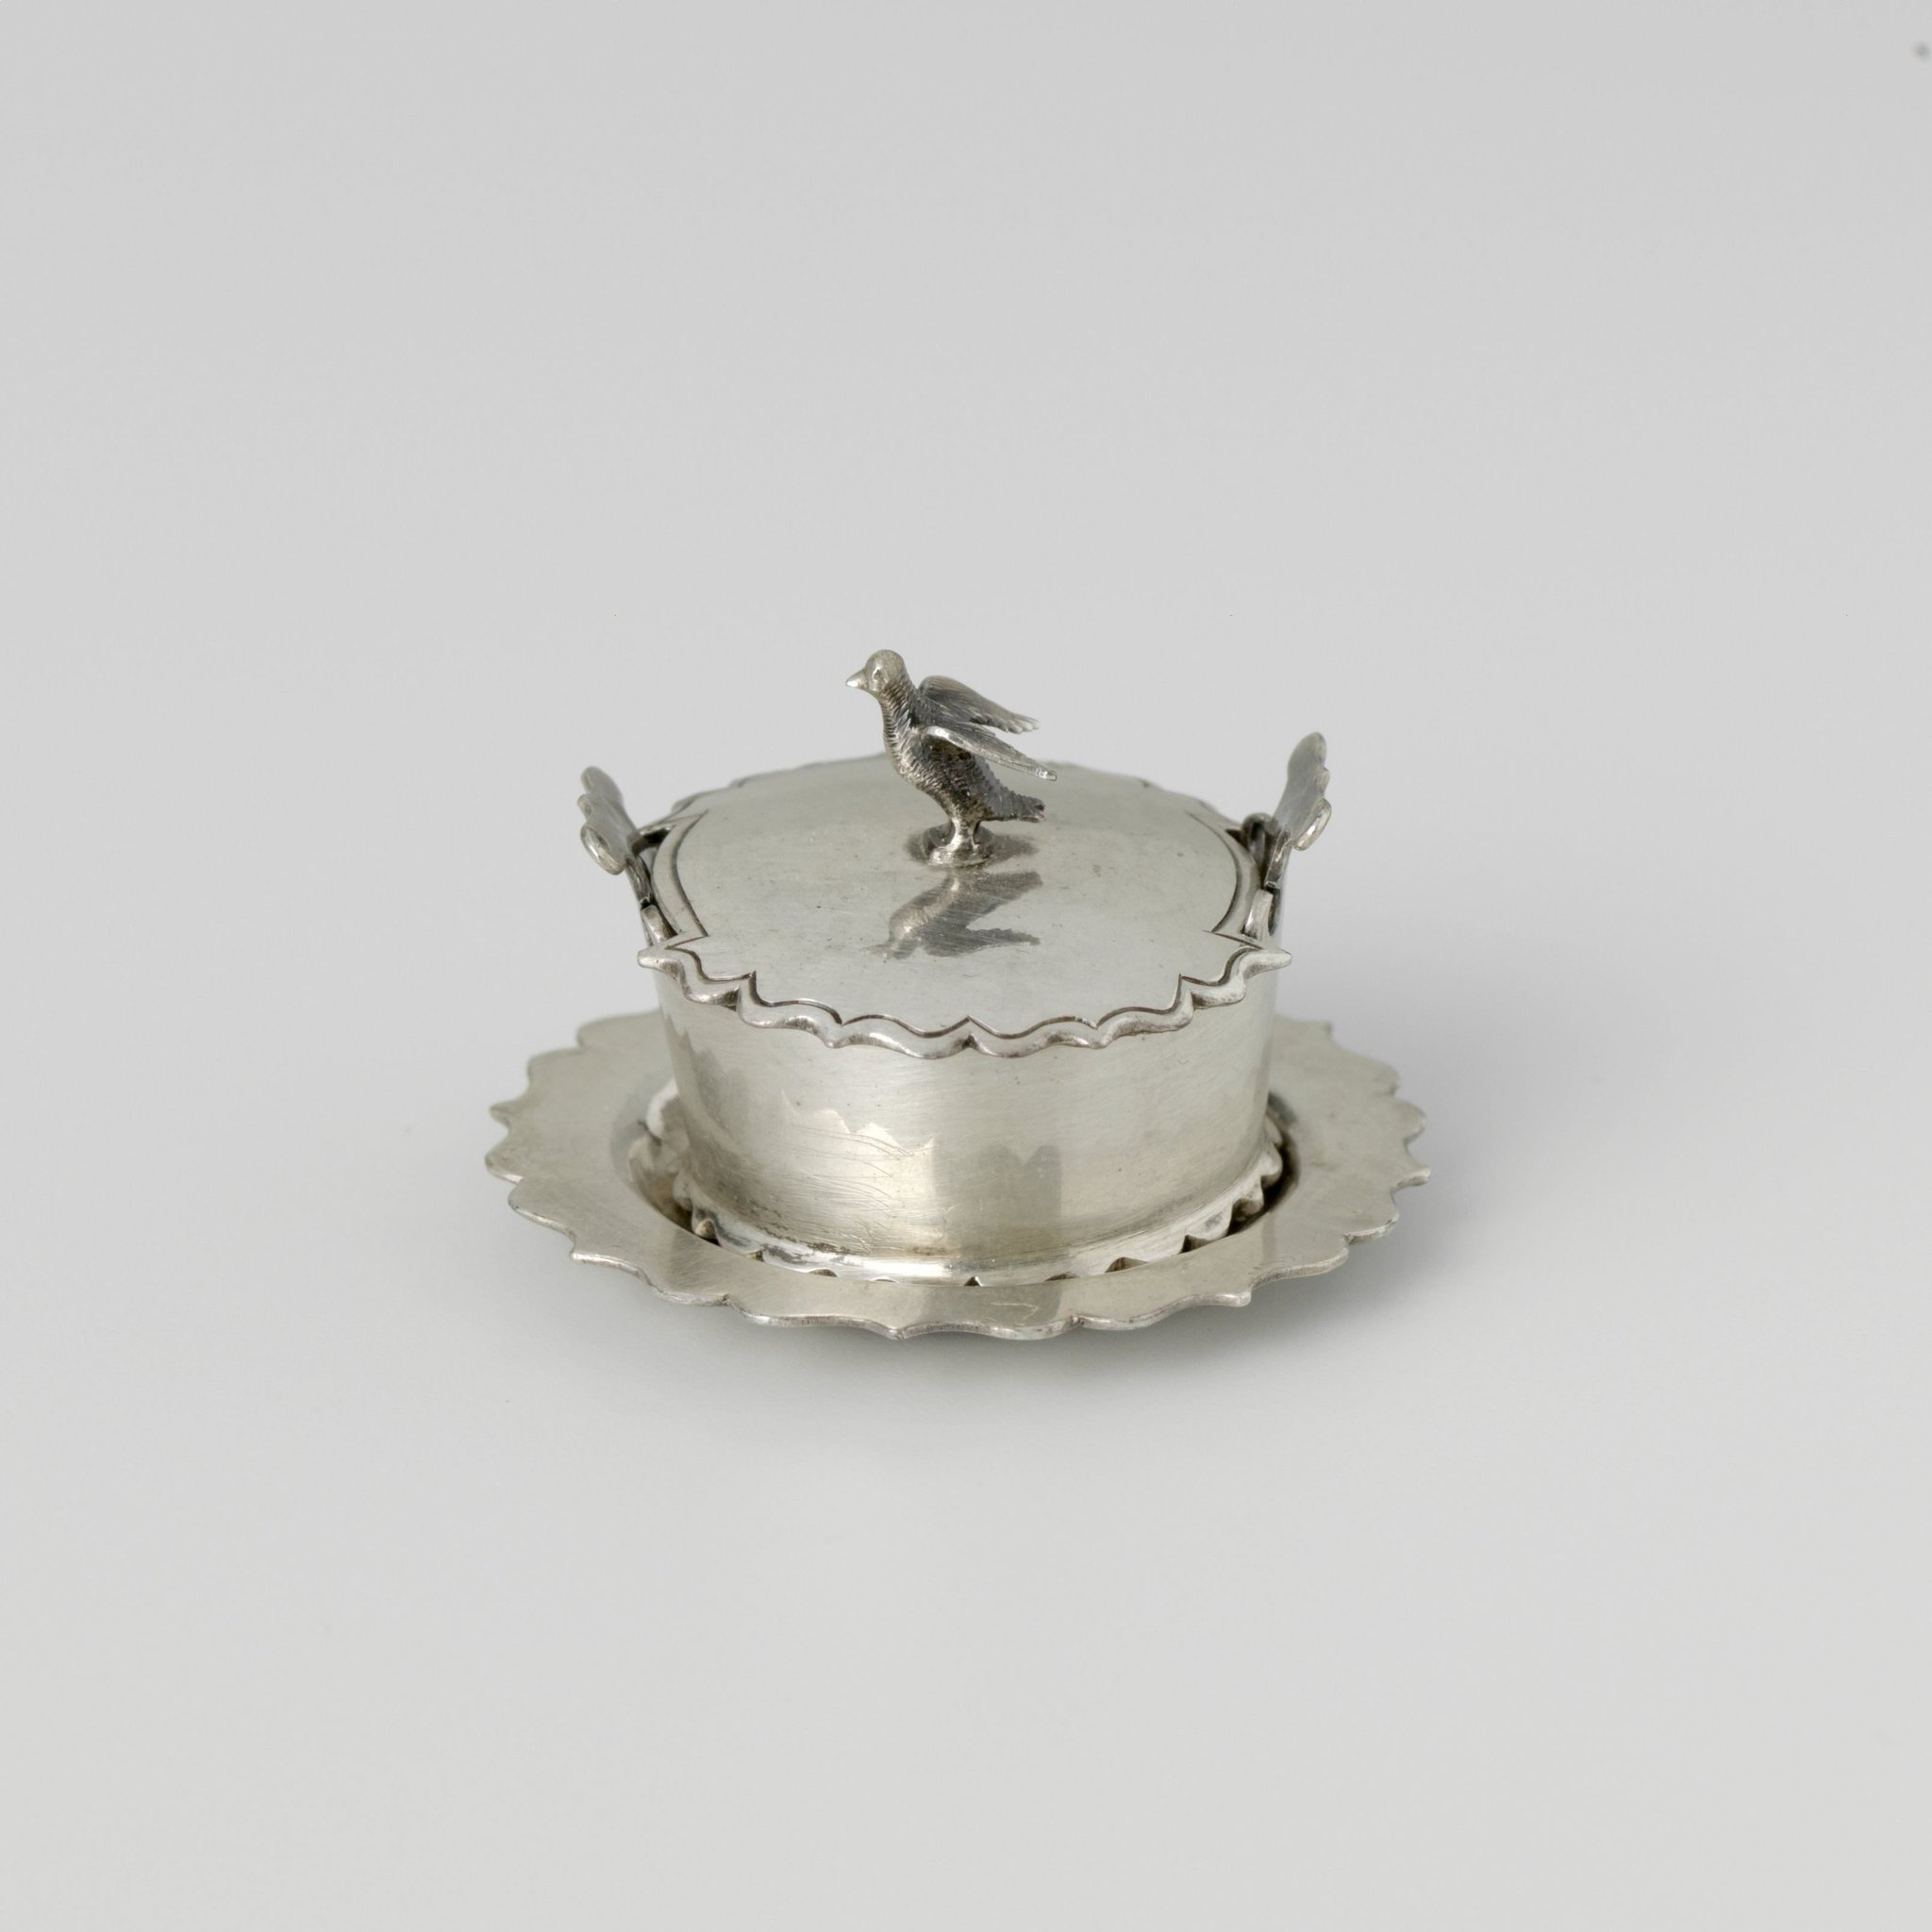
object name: miniature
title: Schotel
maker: arnoldus van geffen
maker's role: silversmith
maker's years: 1700-1769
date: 1766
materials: silver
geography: amsterdam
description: Ronde schotel met geschulpte rand. De schotel hoort onder een terrine (BK-NM-11177-153-b). De terrine is gemerkt, maar de schotel niet. De schotel en de groenteschaal zijn gelijk aan twee exemplaren met invnrs. BK-NM-11177-252 en BK-NM-11177-253.